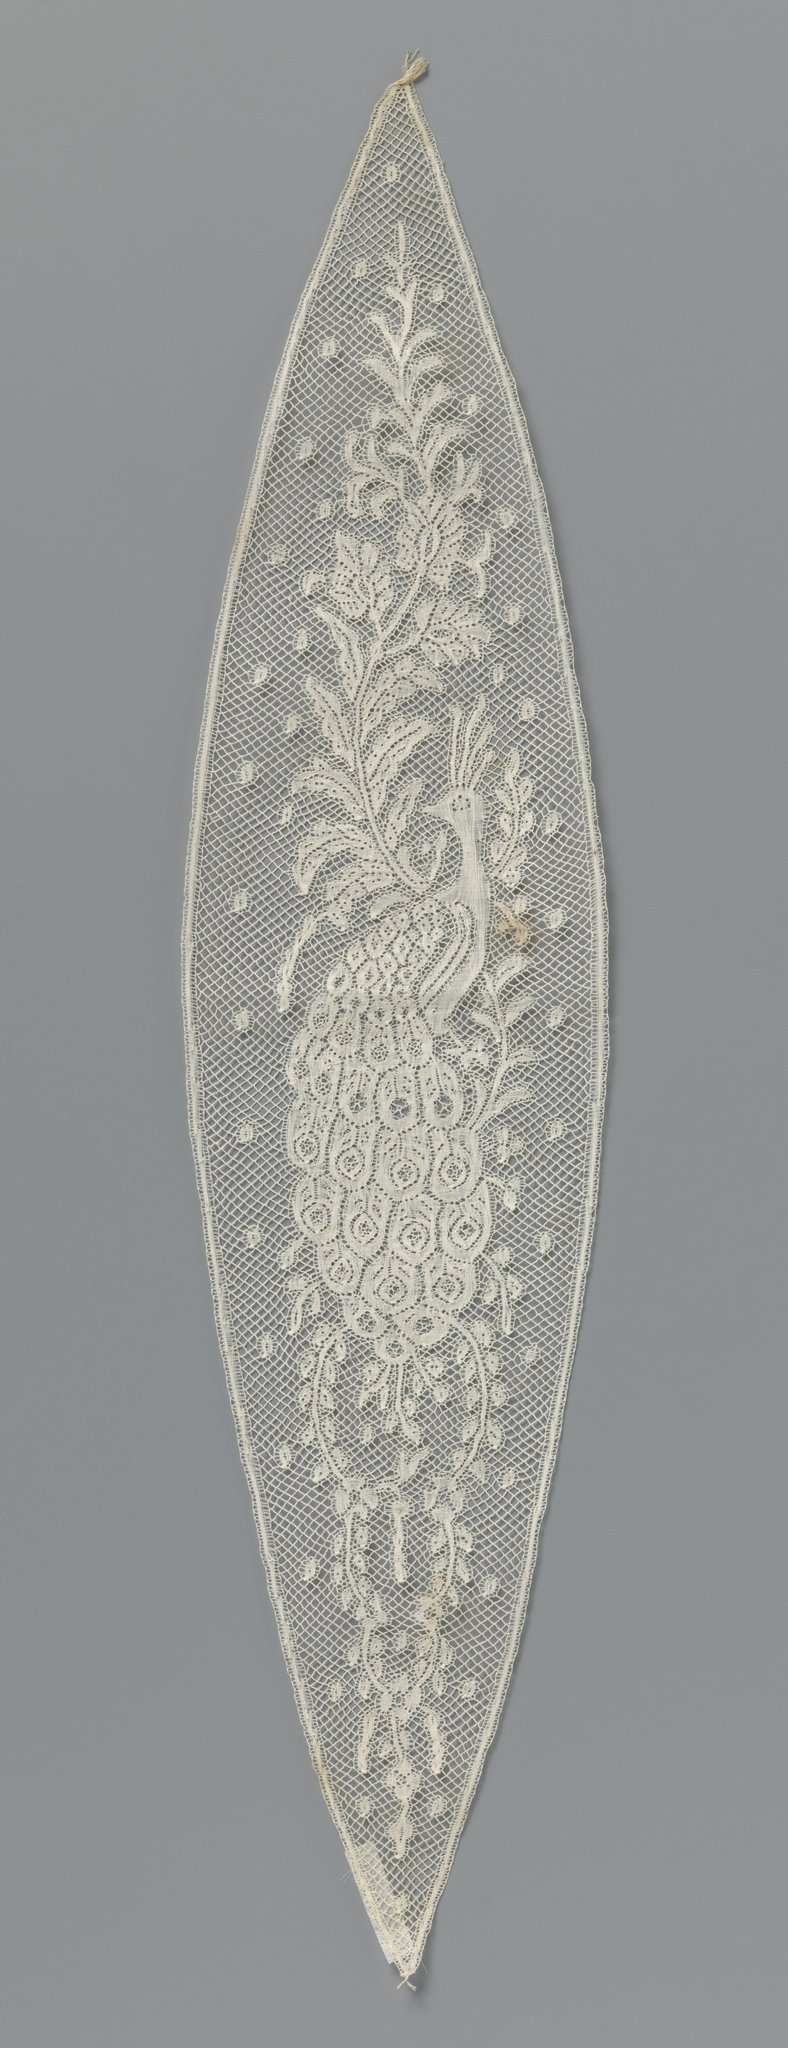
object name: languette de ba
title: Kousinzet van kloskant met pauw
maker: Anonymous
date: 1900-1914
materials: linen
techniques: lace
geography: belgium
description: Kousinzet van naturelkleurige kloskant: Valenciennes-kant. Spitsovaalvormig. In het midden staat een pauw, zijn staart hangt naar beneden en gaat over in drie aaneengeschakelde kransen. Een lange bloemtak loopt achter de pauw langs omhoog, tot in de punt van de kousinzet. De motieven zijn gemaakt in linnenslag met uitsparingen en opengewerkte randjes. In de staartveren en de bloemharten is een siergrond toegepast. De motieven zijn met elkaar verbonden door een traliegrond, een ruitvormige Valenciennes-grond, bezaaid met moesjes. De zijden zijn recht afgewerkt.